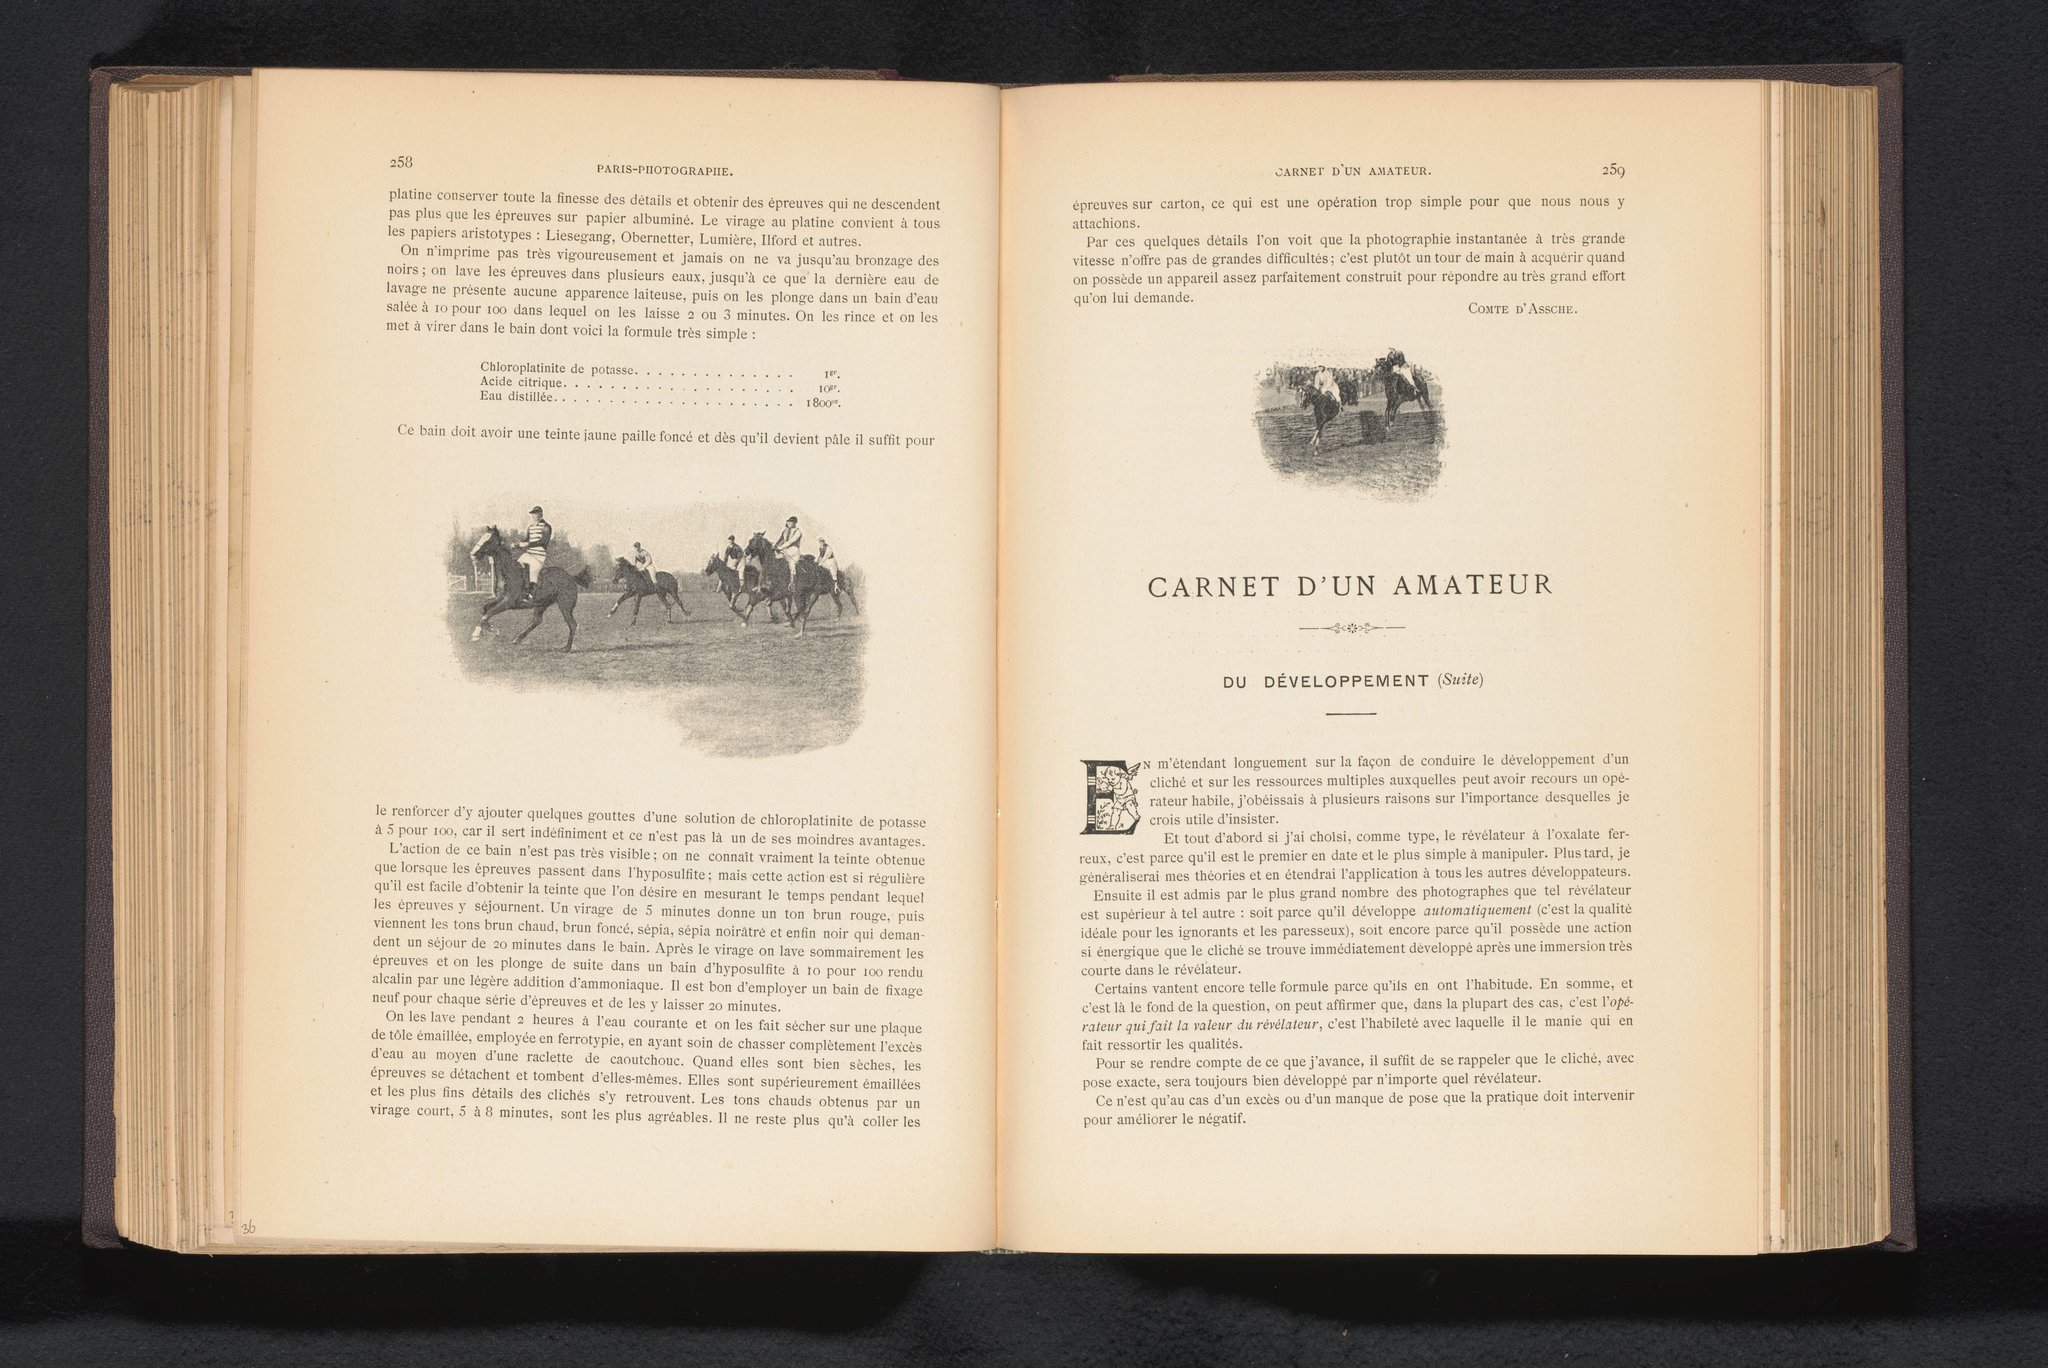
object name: page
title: Mannen op galopperende paarden, mogelijk tijdens een wedstrijd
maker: Anonymous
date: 1882-1892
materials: paper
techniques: autotype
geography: france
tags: riding a horse, ass, or mule; rider, horseman, horse